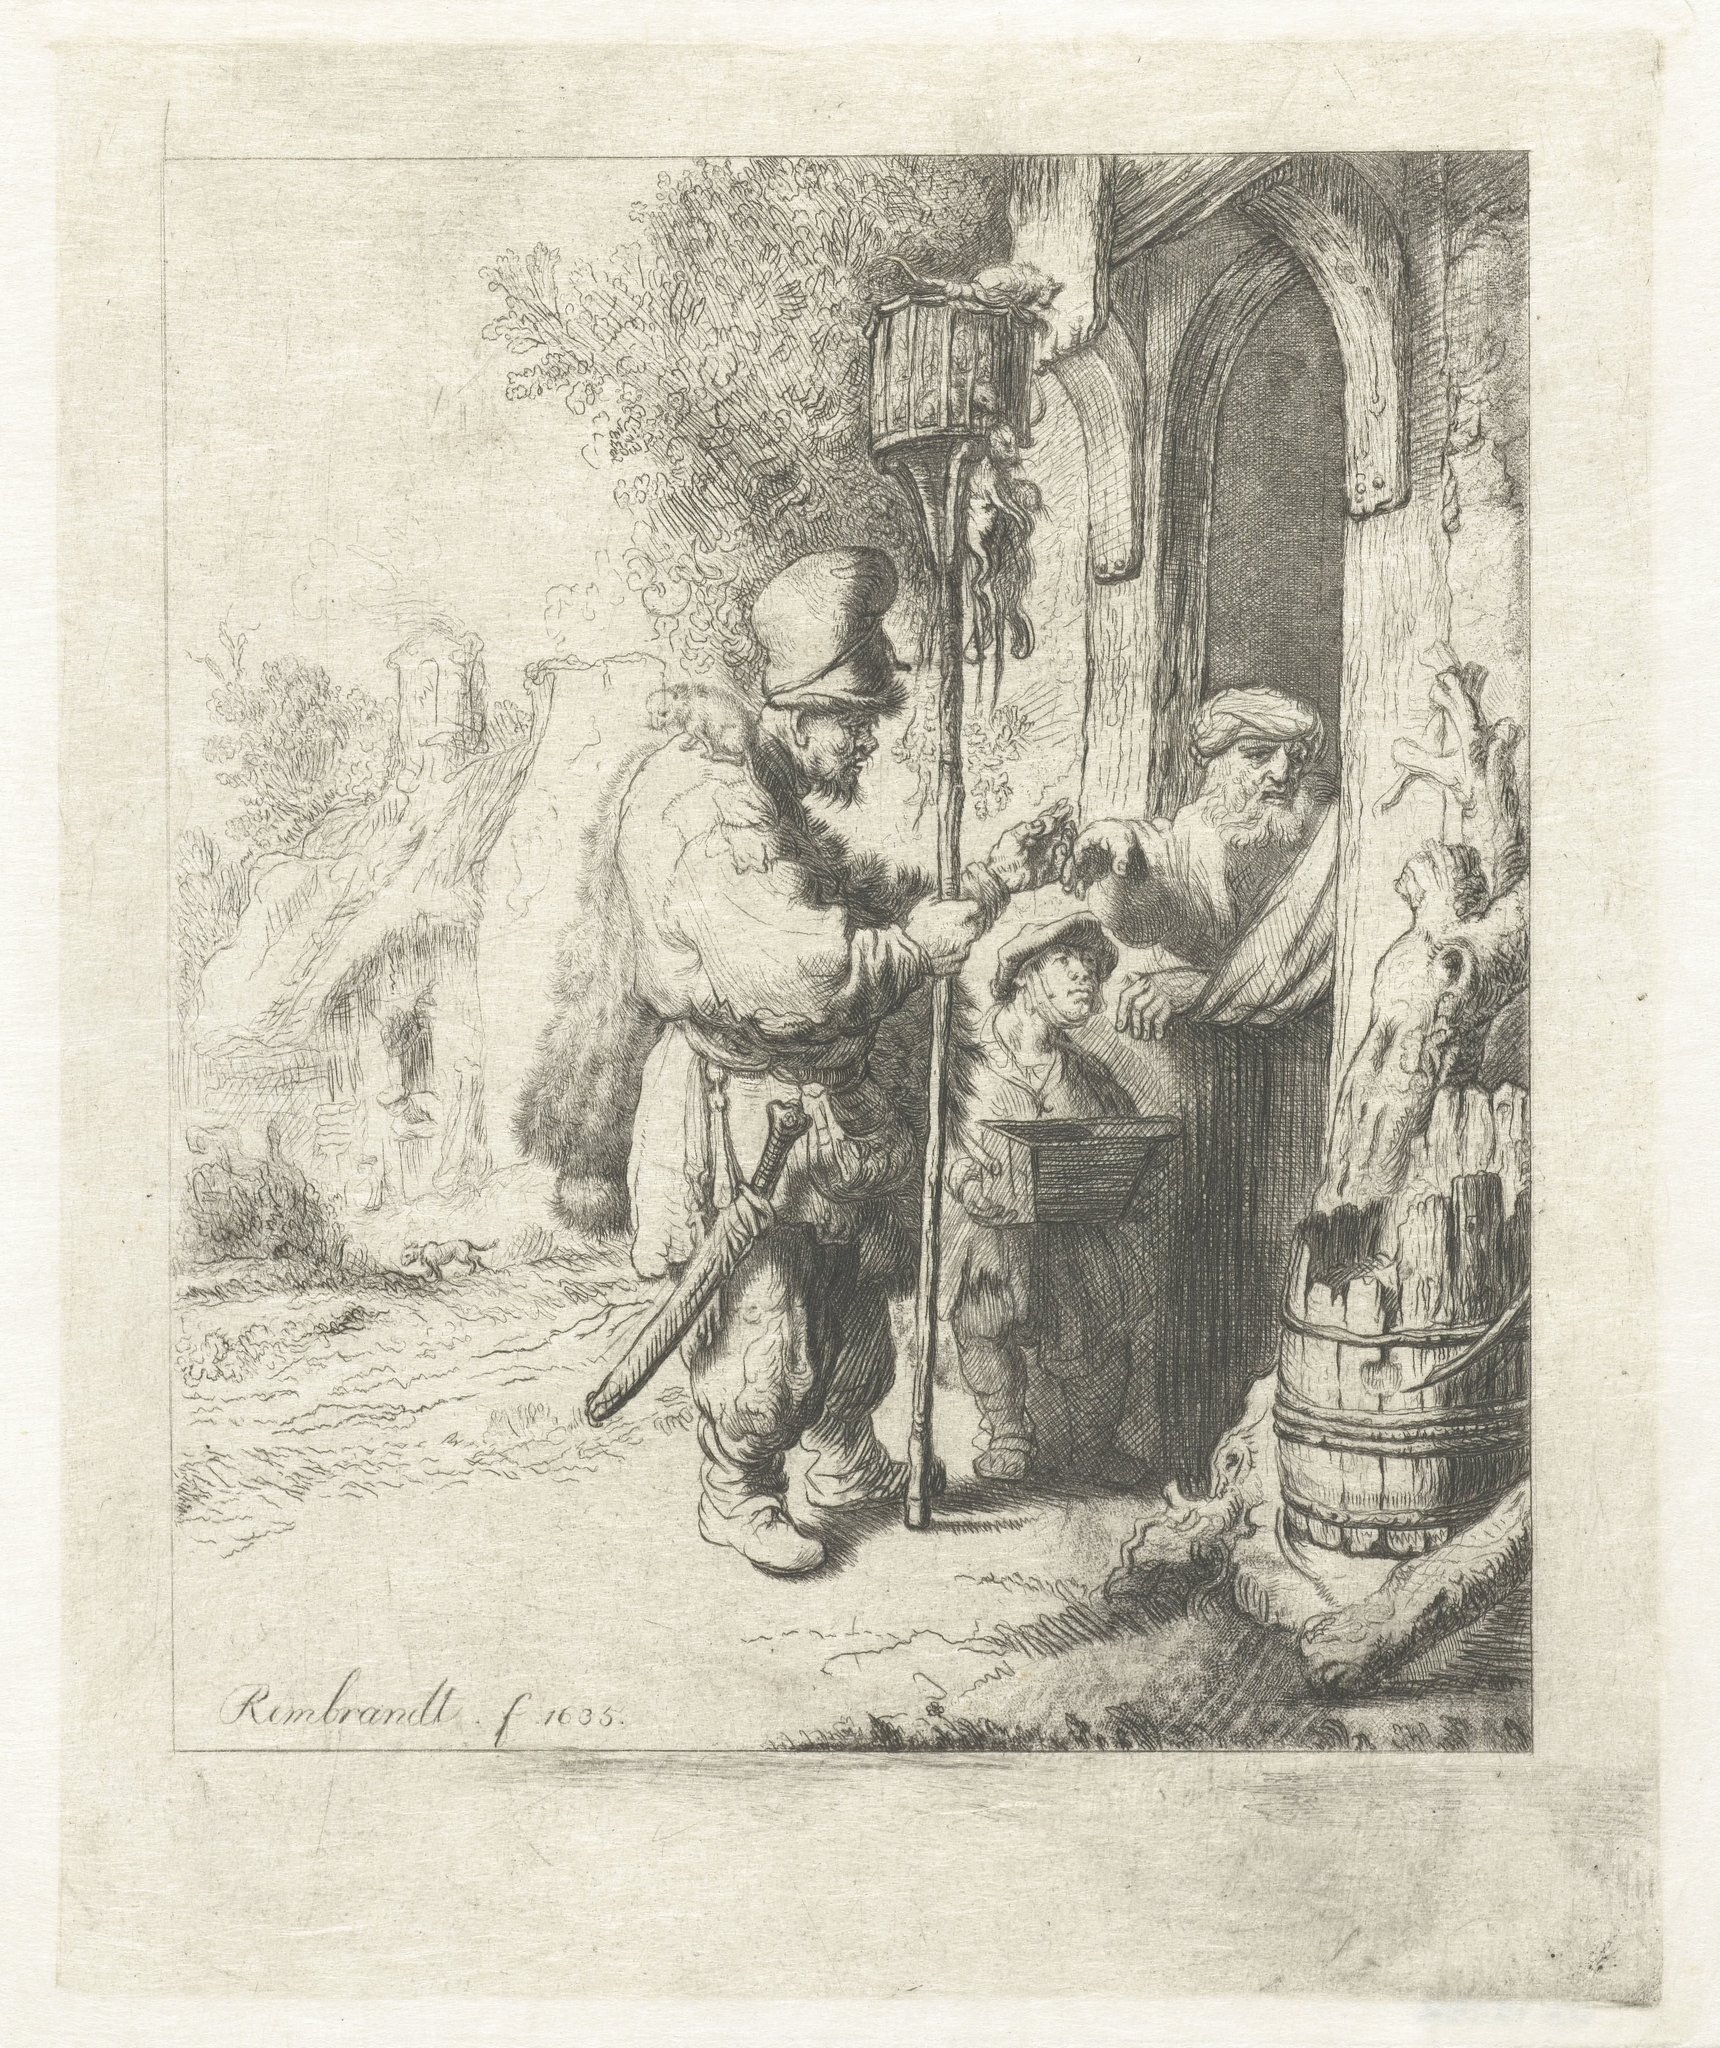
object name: print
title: The rat catcher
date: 1632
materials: paper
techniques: etching, intaglio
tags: rat exterminator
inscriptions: collector's mark: Lugt 2228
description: Spiegelbeeldige kopie naar de gelijknamige prent van Rembrandt.